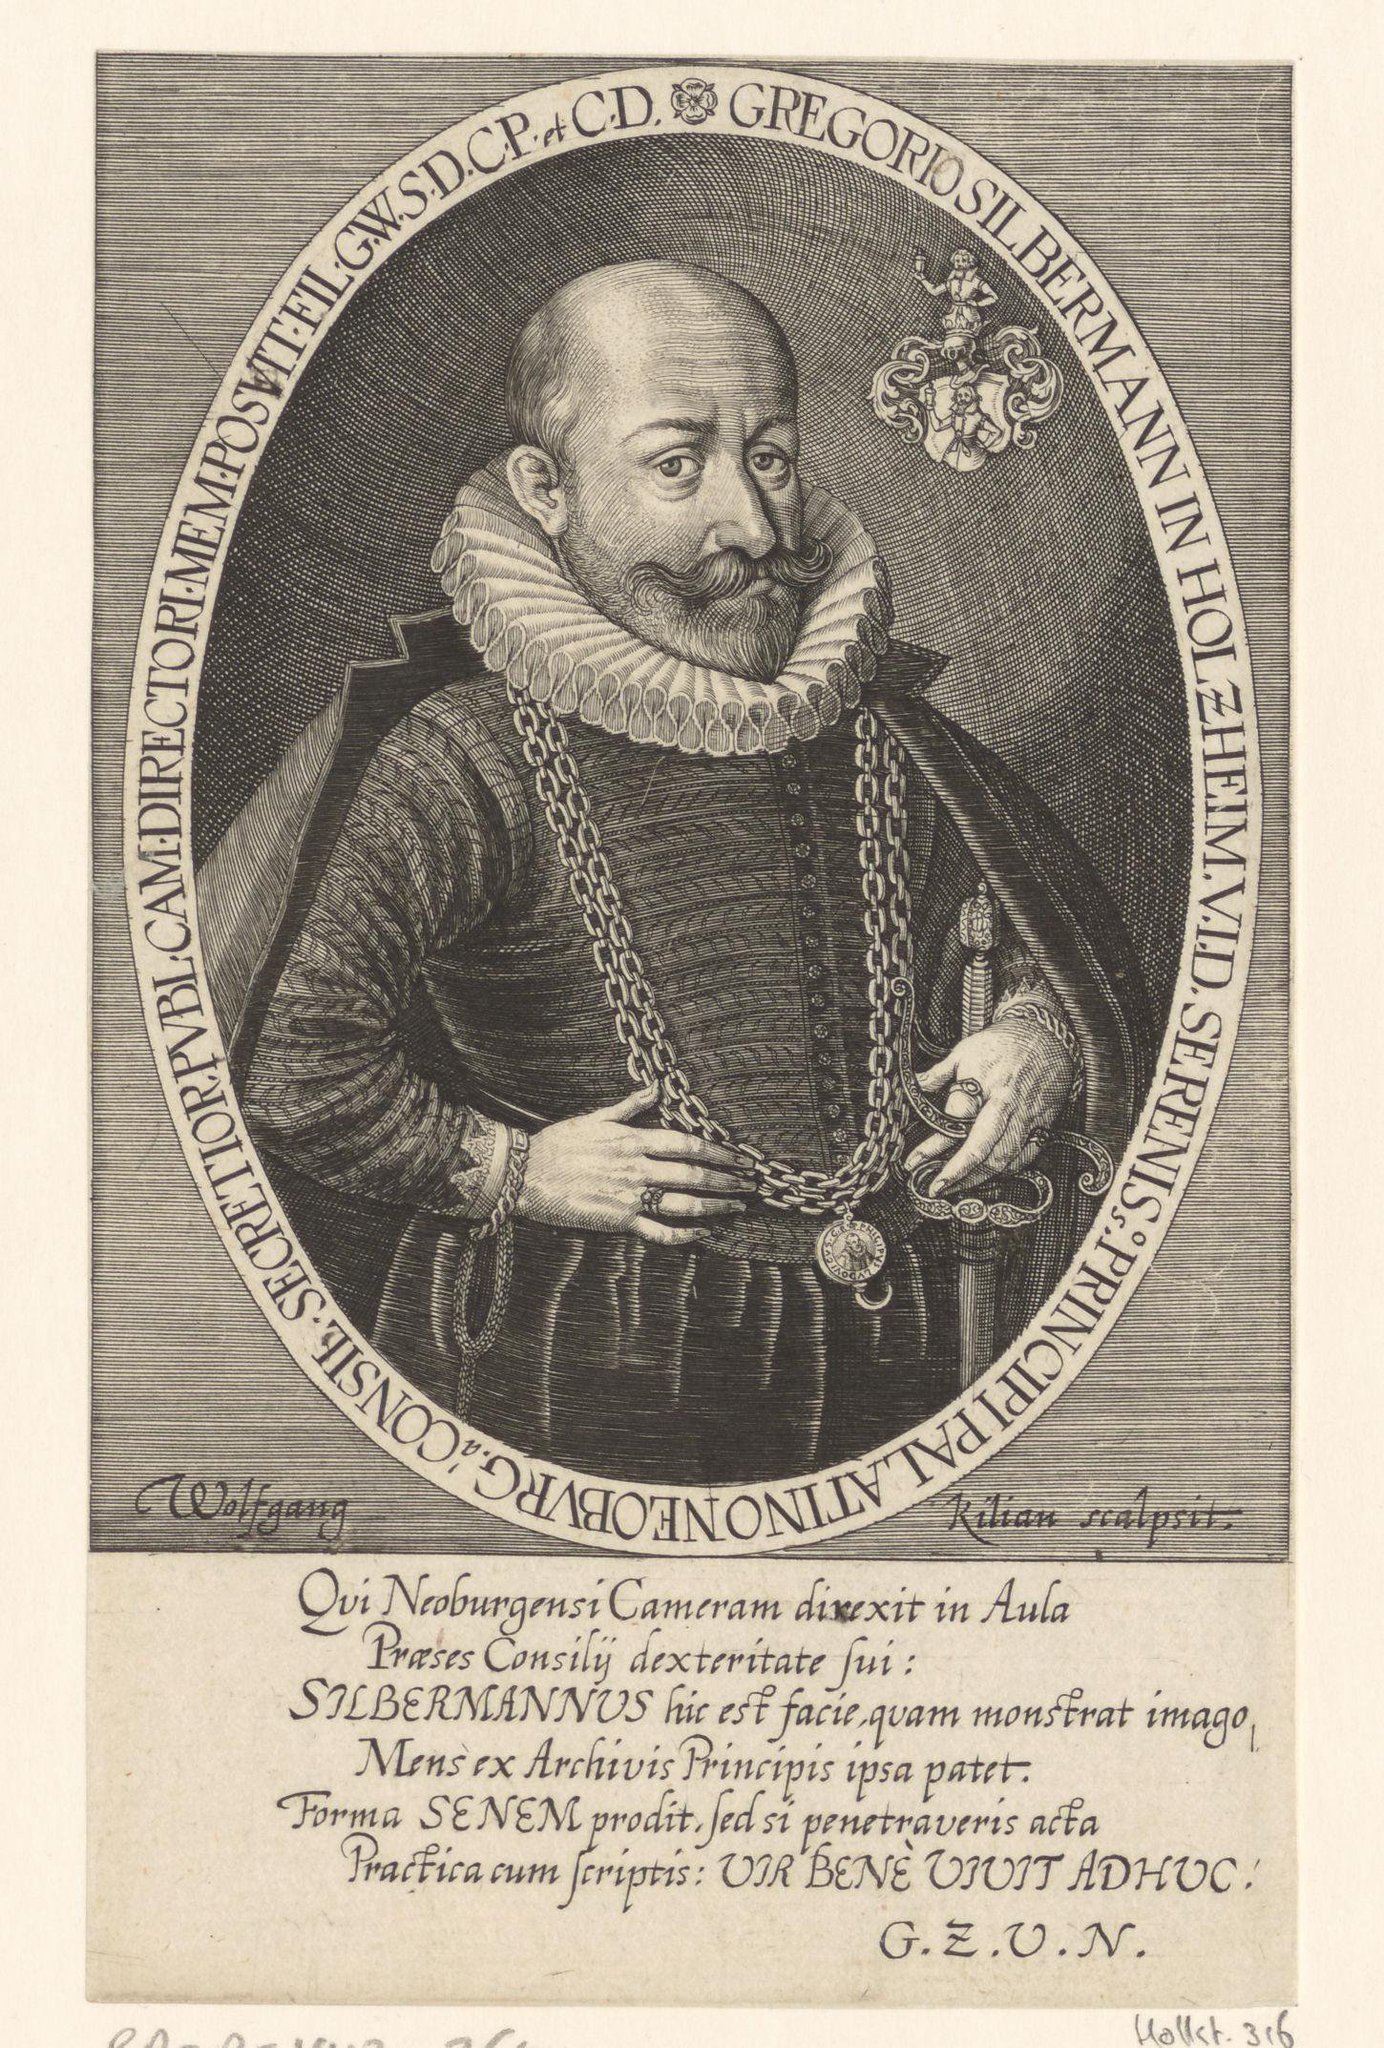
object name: print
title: Portret van Gregor Silbermann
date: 1591-1662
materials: paper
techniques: engraving, etching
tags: historical persons, lawyer, attorney at law, counsellor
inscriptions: collector's mark: Lugt 2228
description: Tekst in het Latijn in de omlijsting en in de ondermarge.